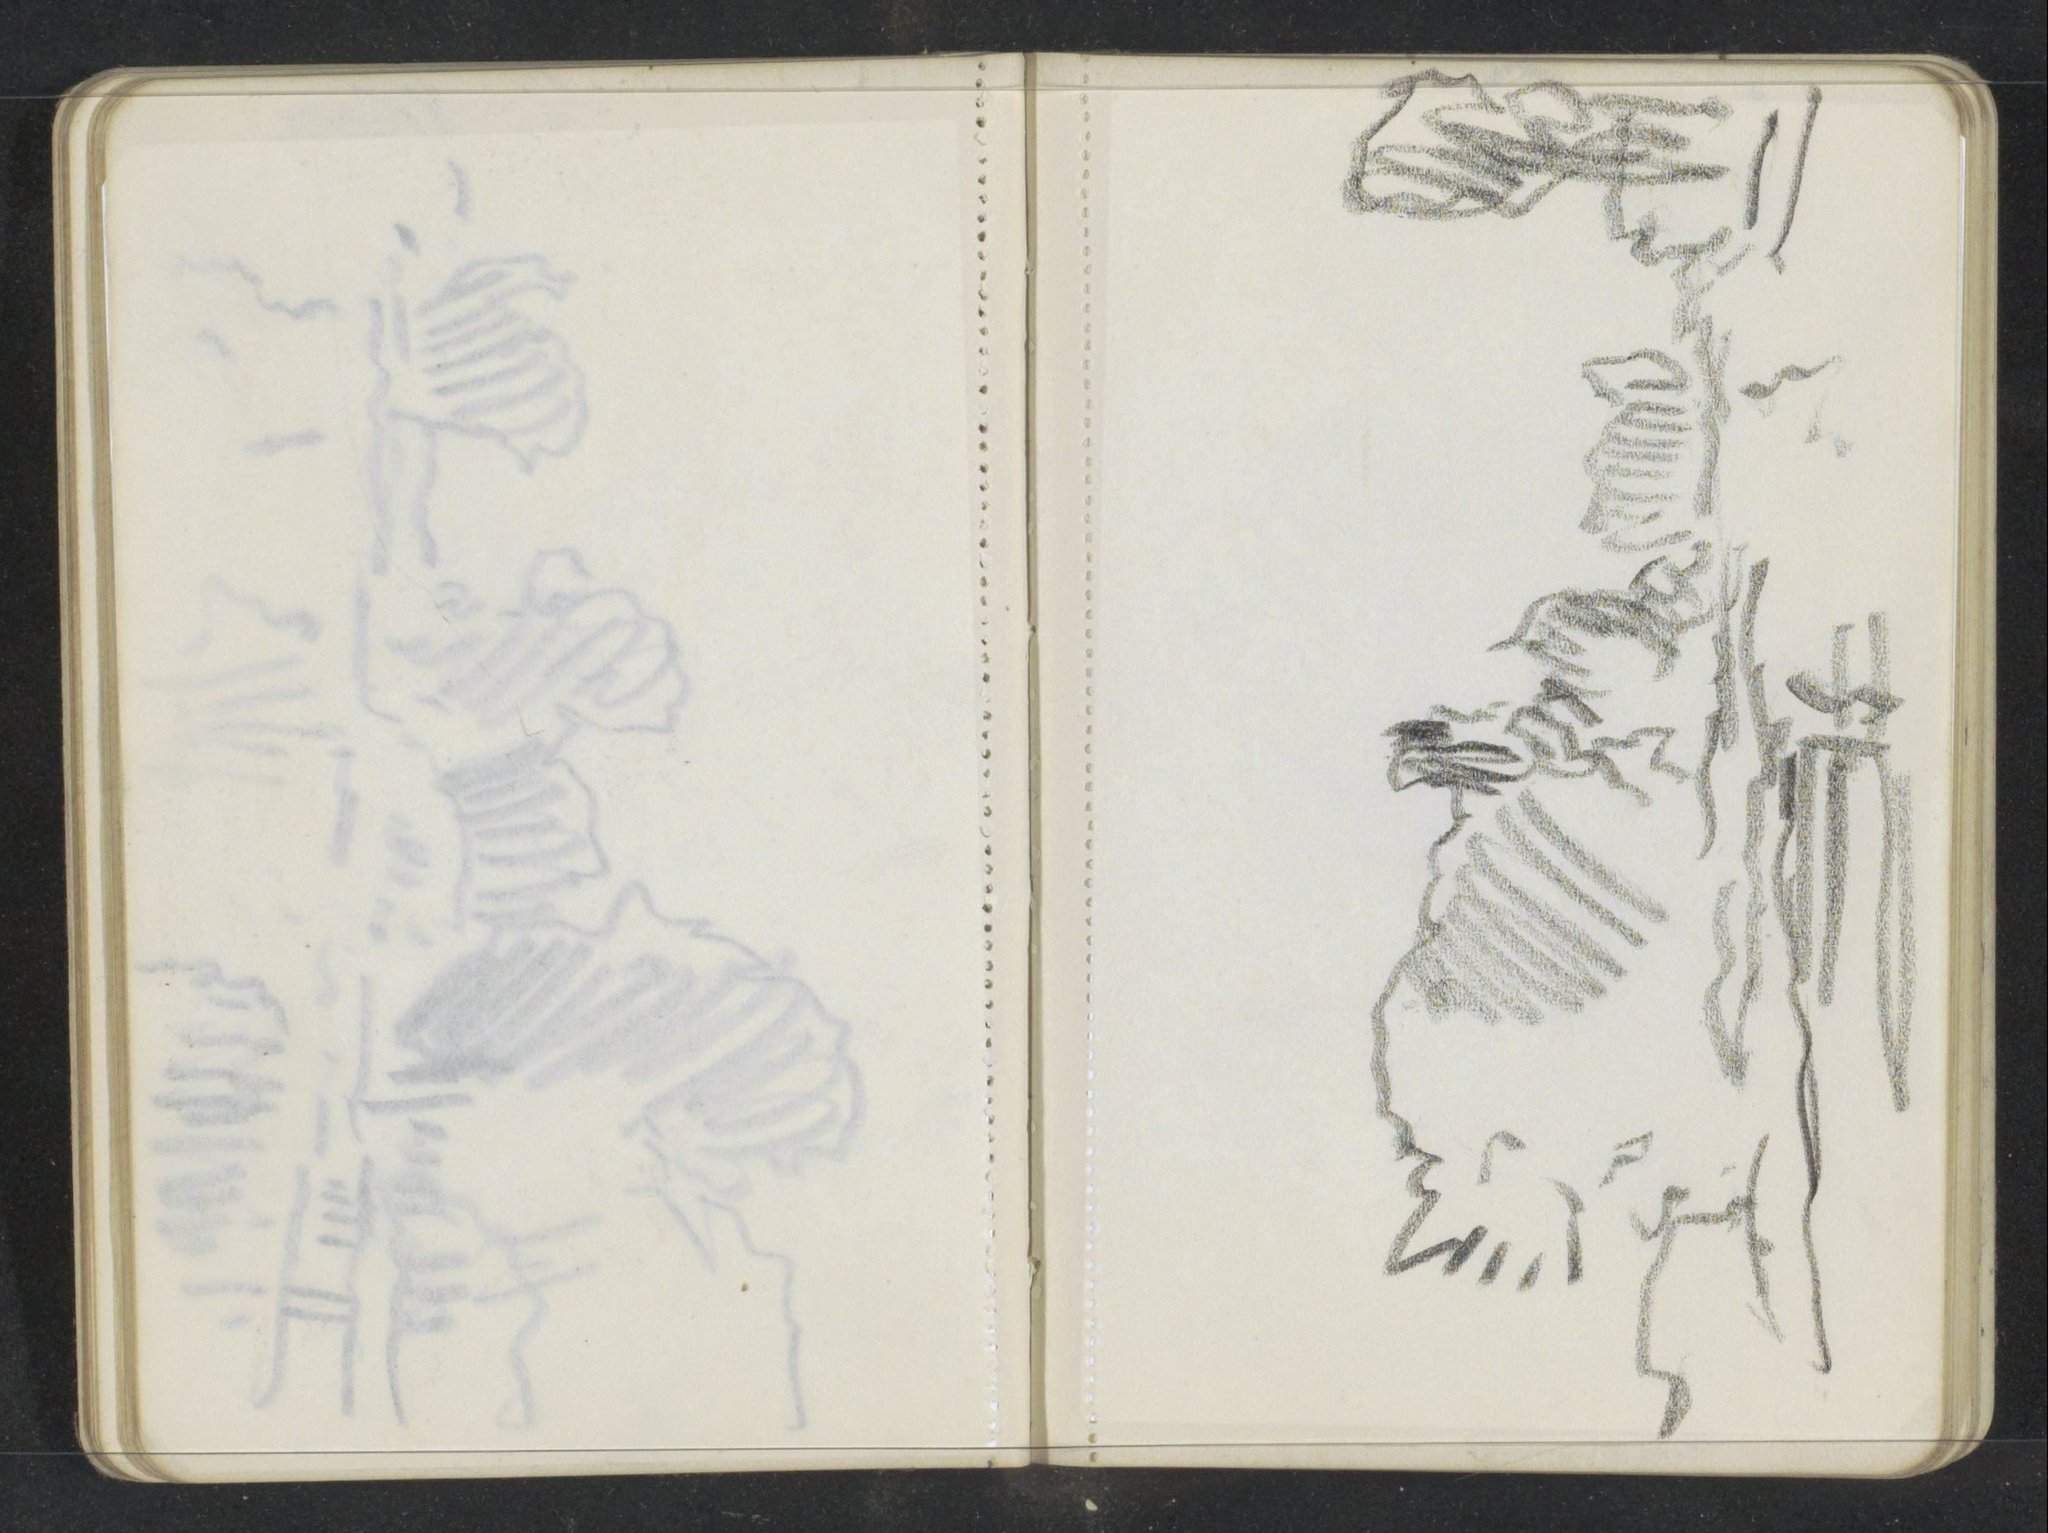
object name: sketchbook leaf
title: Bomen aan een waterkant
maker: alexander shilling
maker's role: draughtsman, print maker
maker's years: 1859-1937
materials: chalk, paper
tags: trees, landscapes with waters, waterscapes, seascapes (in the temperate zone)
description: Blad 32 recto uit een schetsboek met 91 bladen.